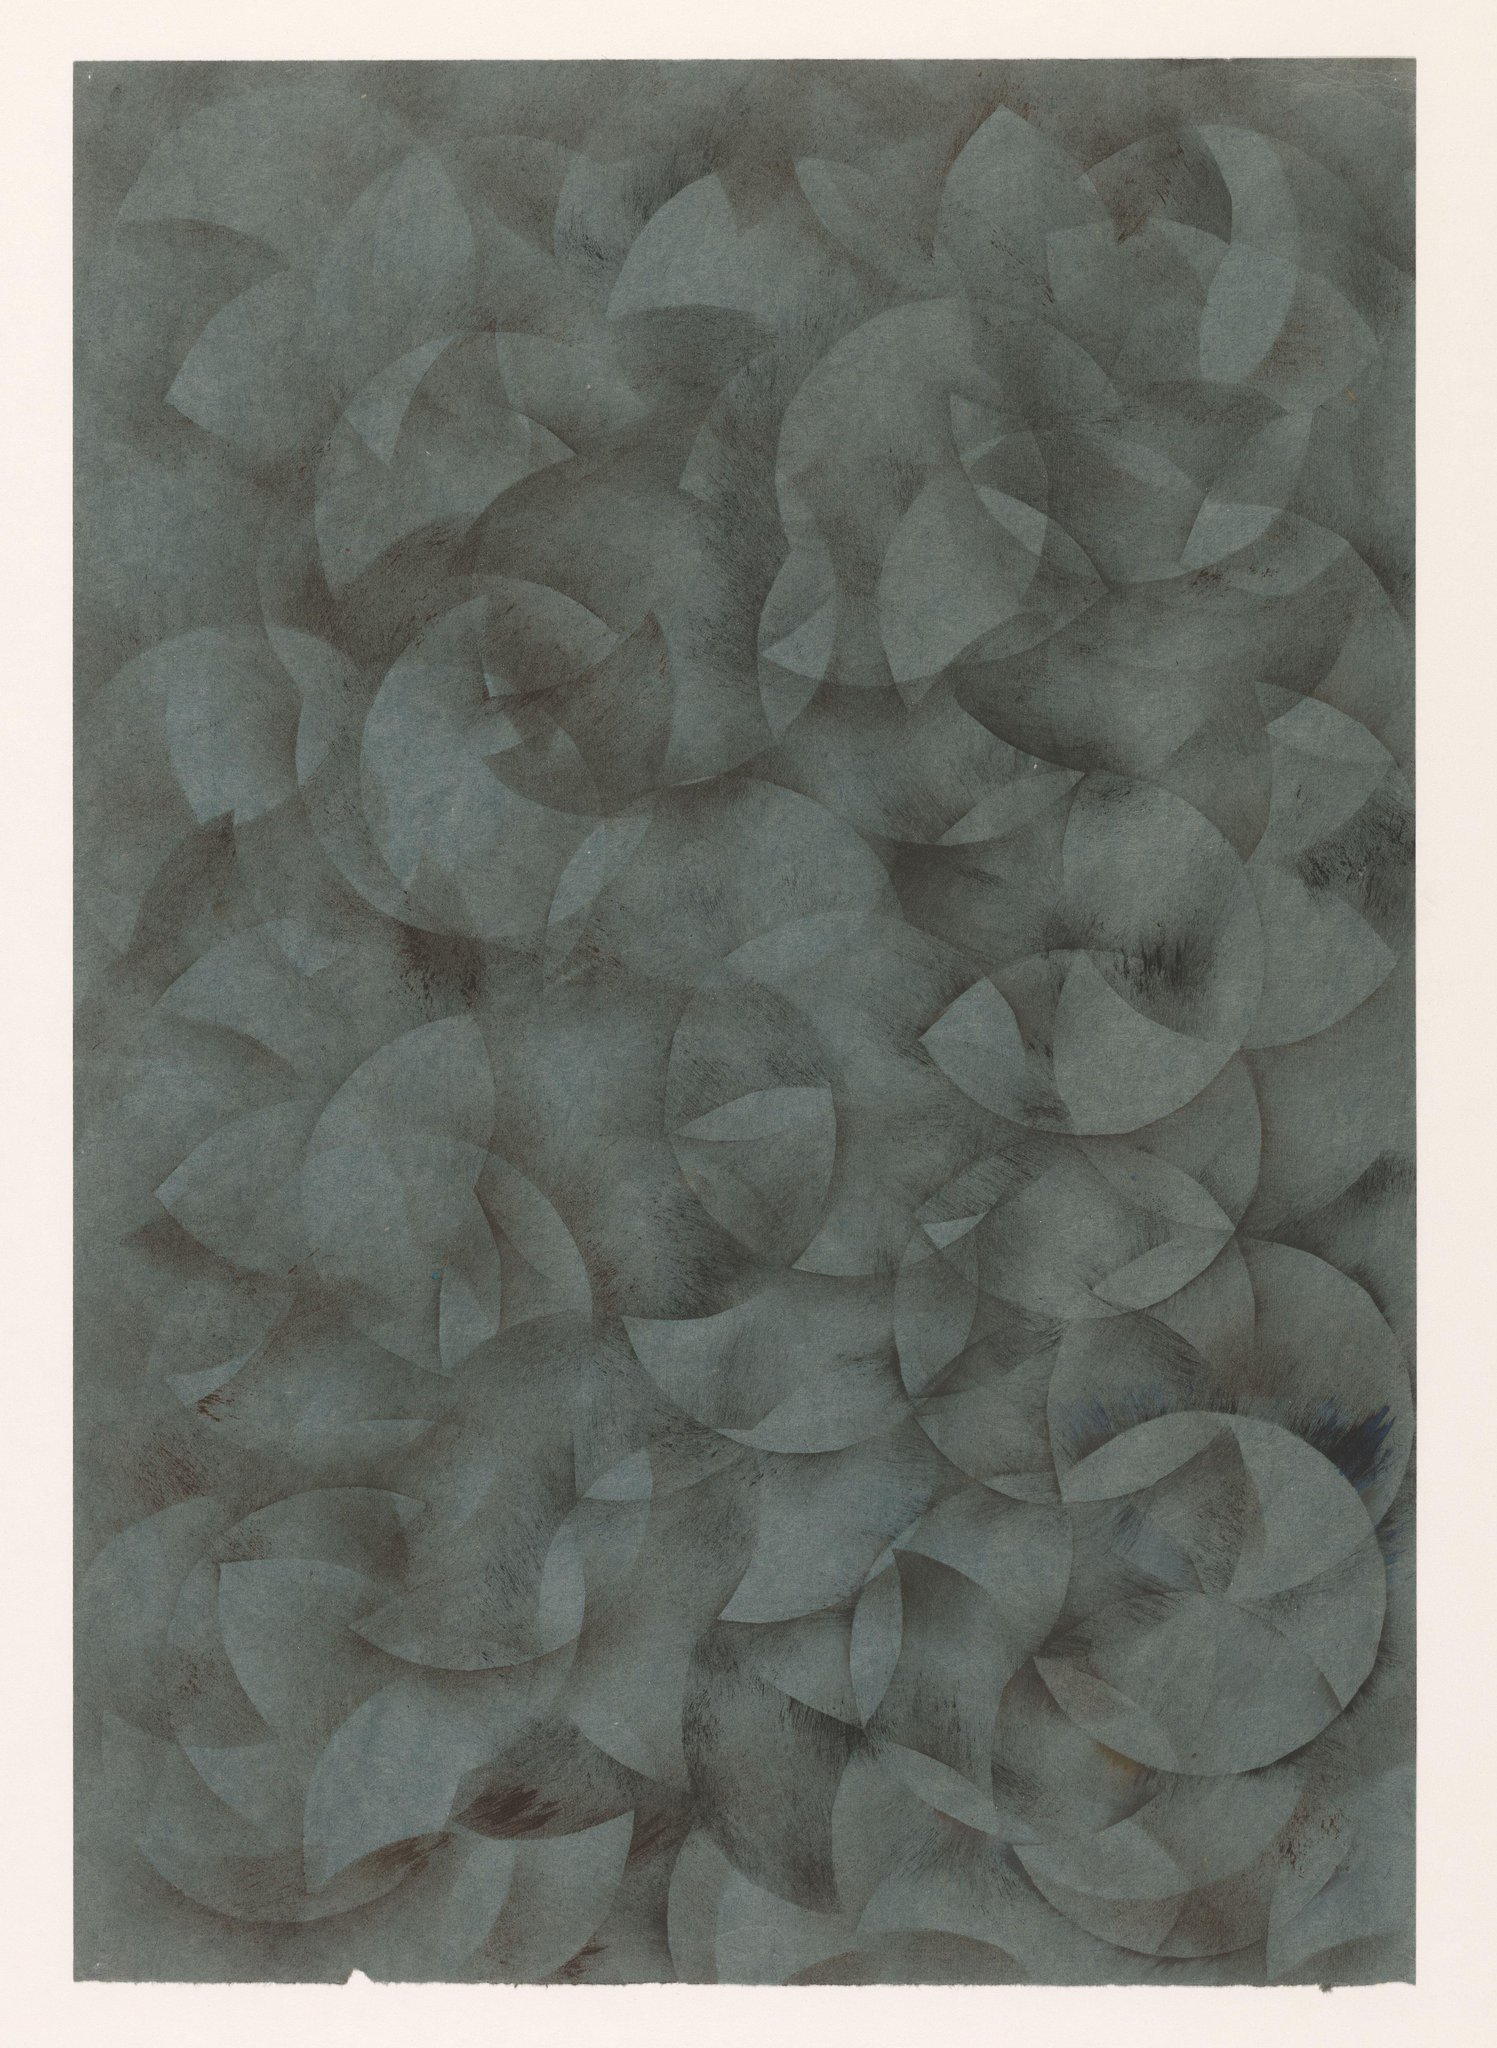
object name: decorated paper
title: Gesjabloneerd papier met patroon van overlappende cirkels in zwart op blauw papier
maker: Anonymous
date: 1900-1969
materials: paint, paper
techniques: stenciling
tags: ornament ~ geometric motifs